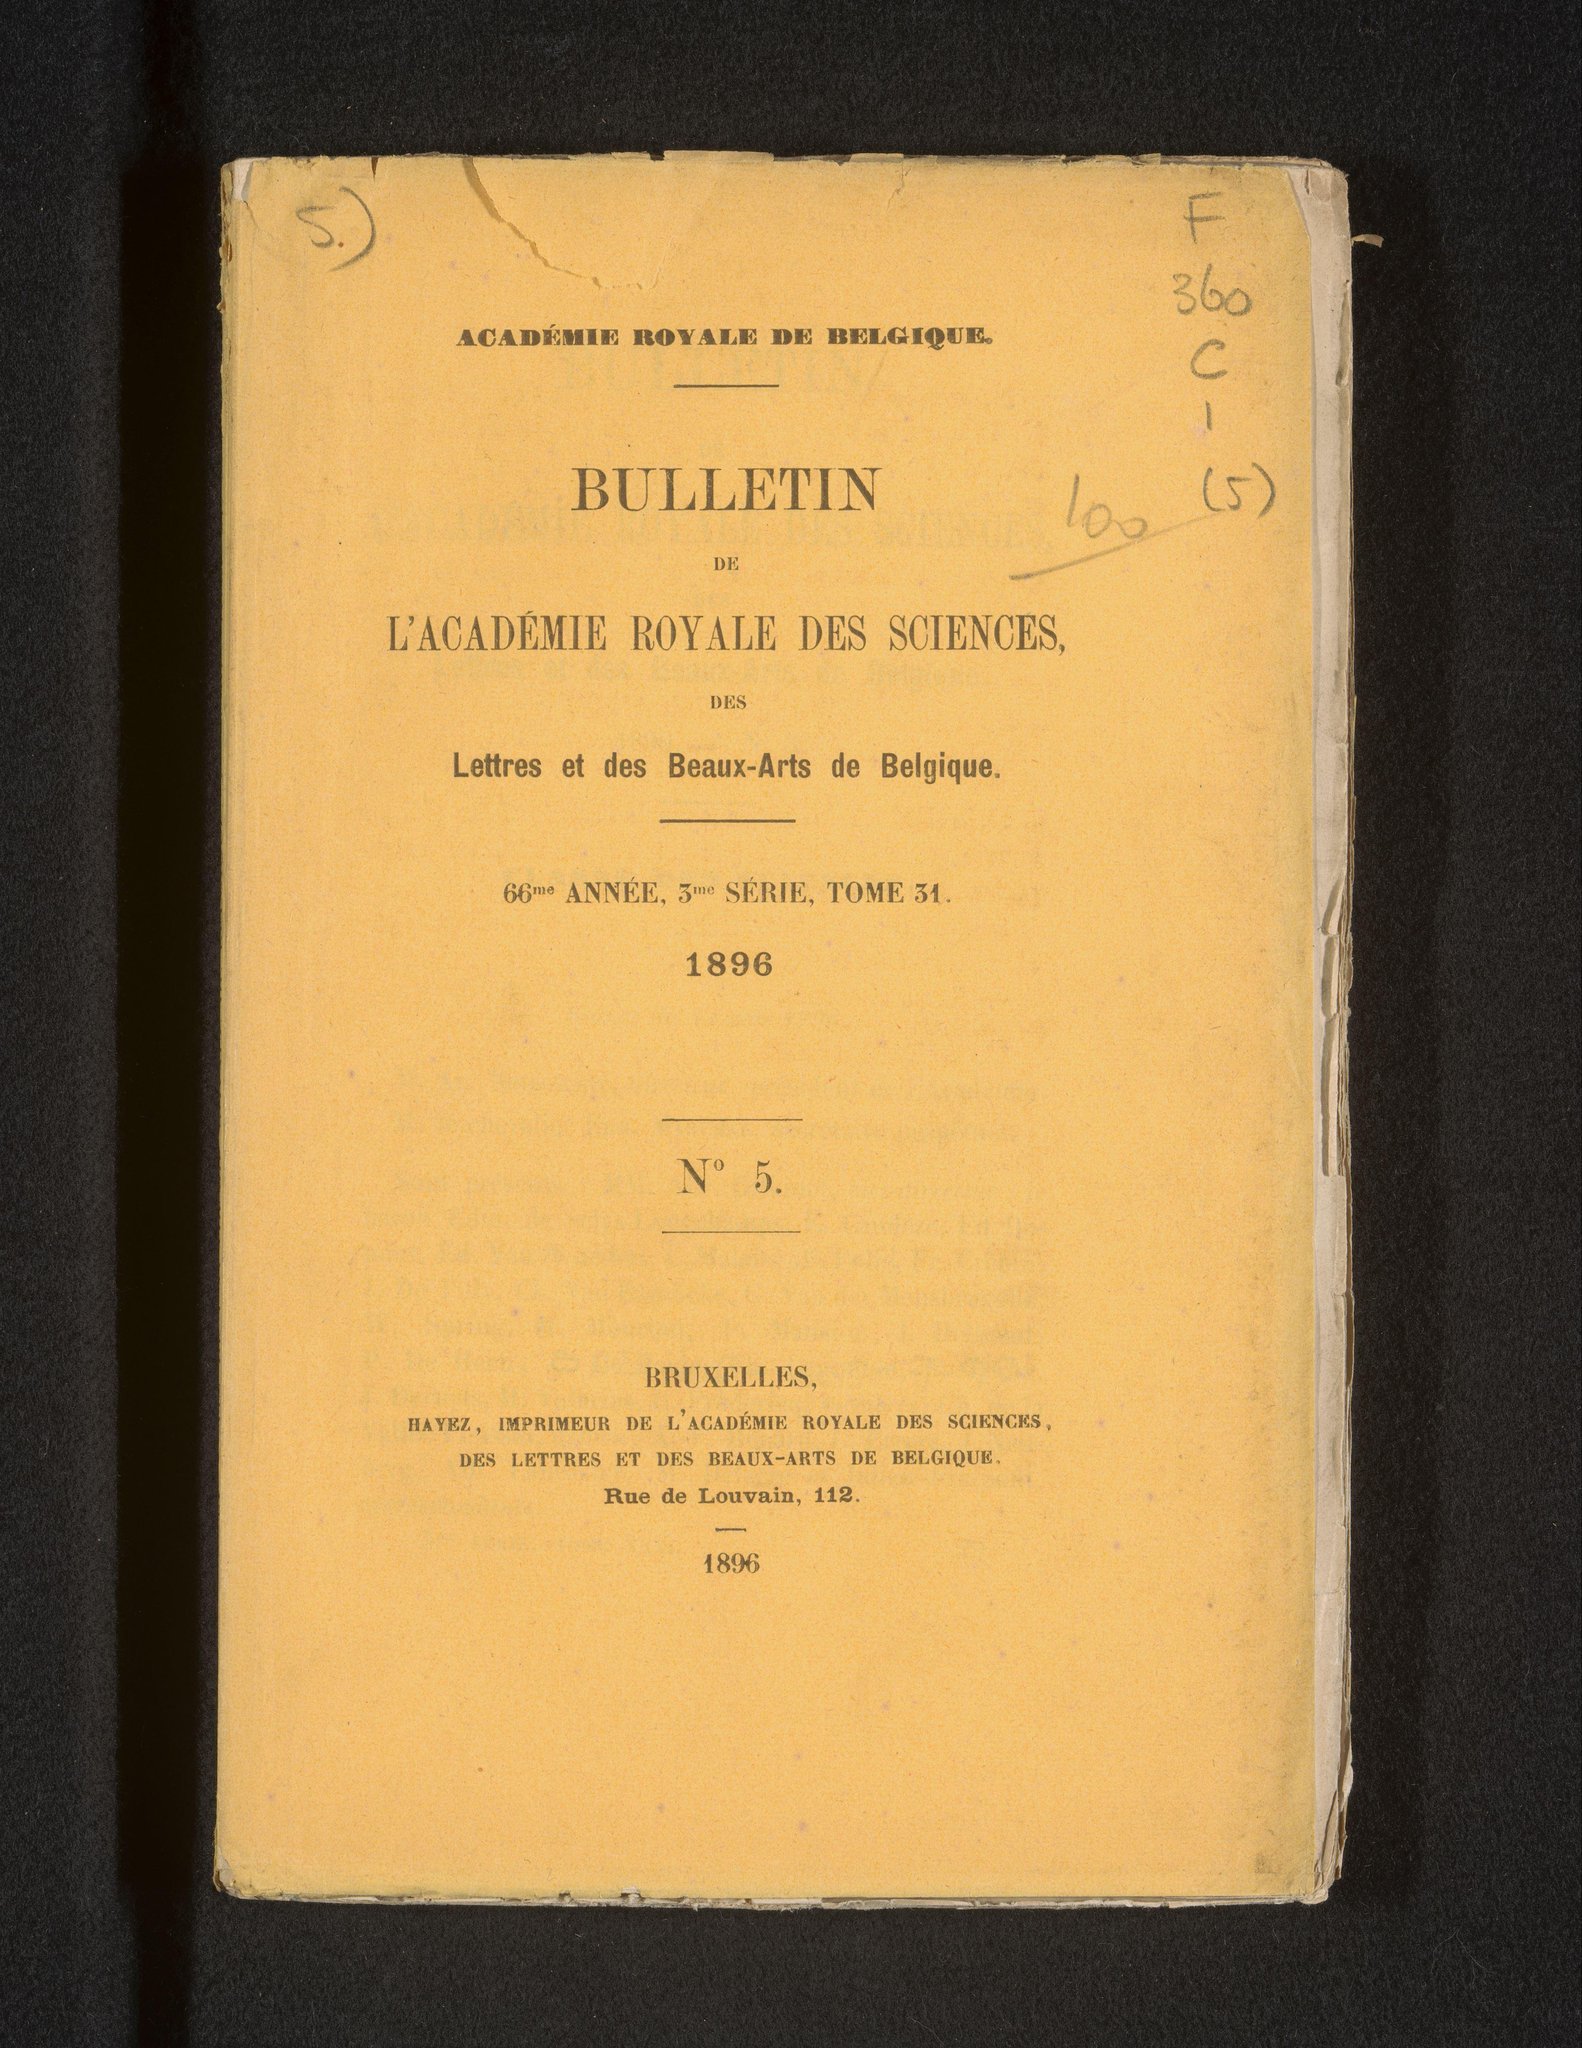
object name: magazine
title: Bulletins de l'Academie royale des sciences, des lettres et des beaux-arts de Belgique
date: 1896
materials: paper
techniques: photograph, printing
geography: brussels